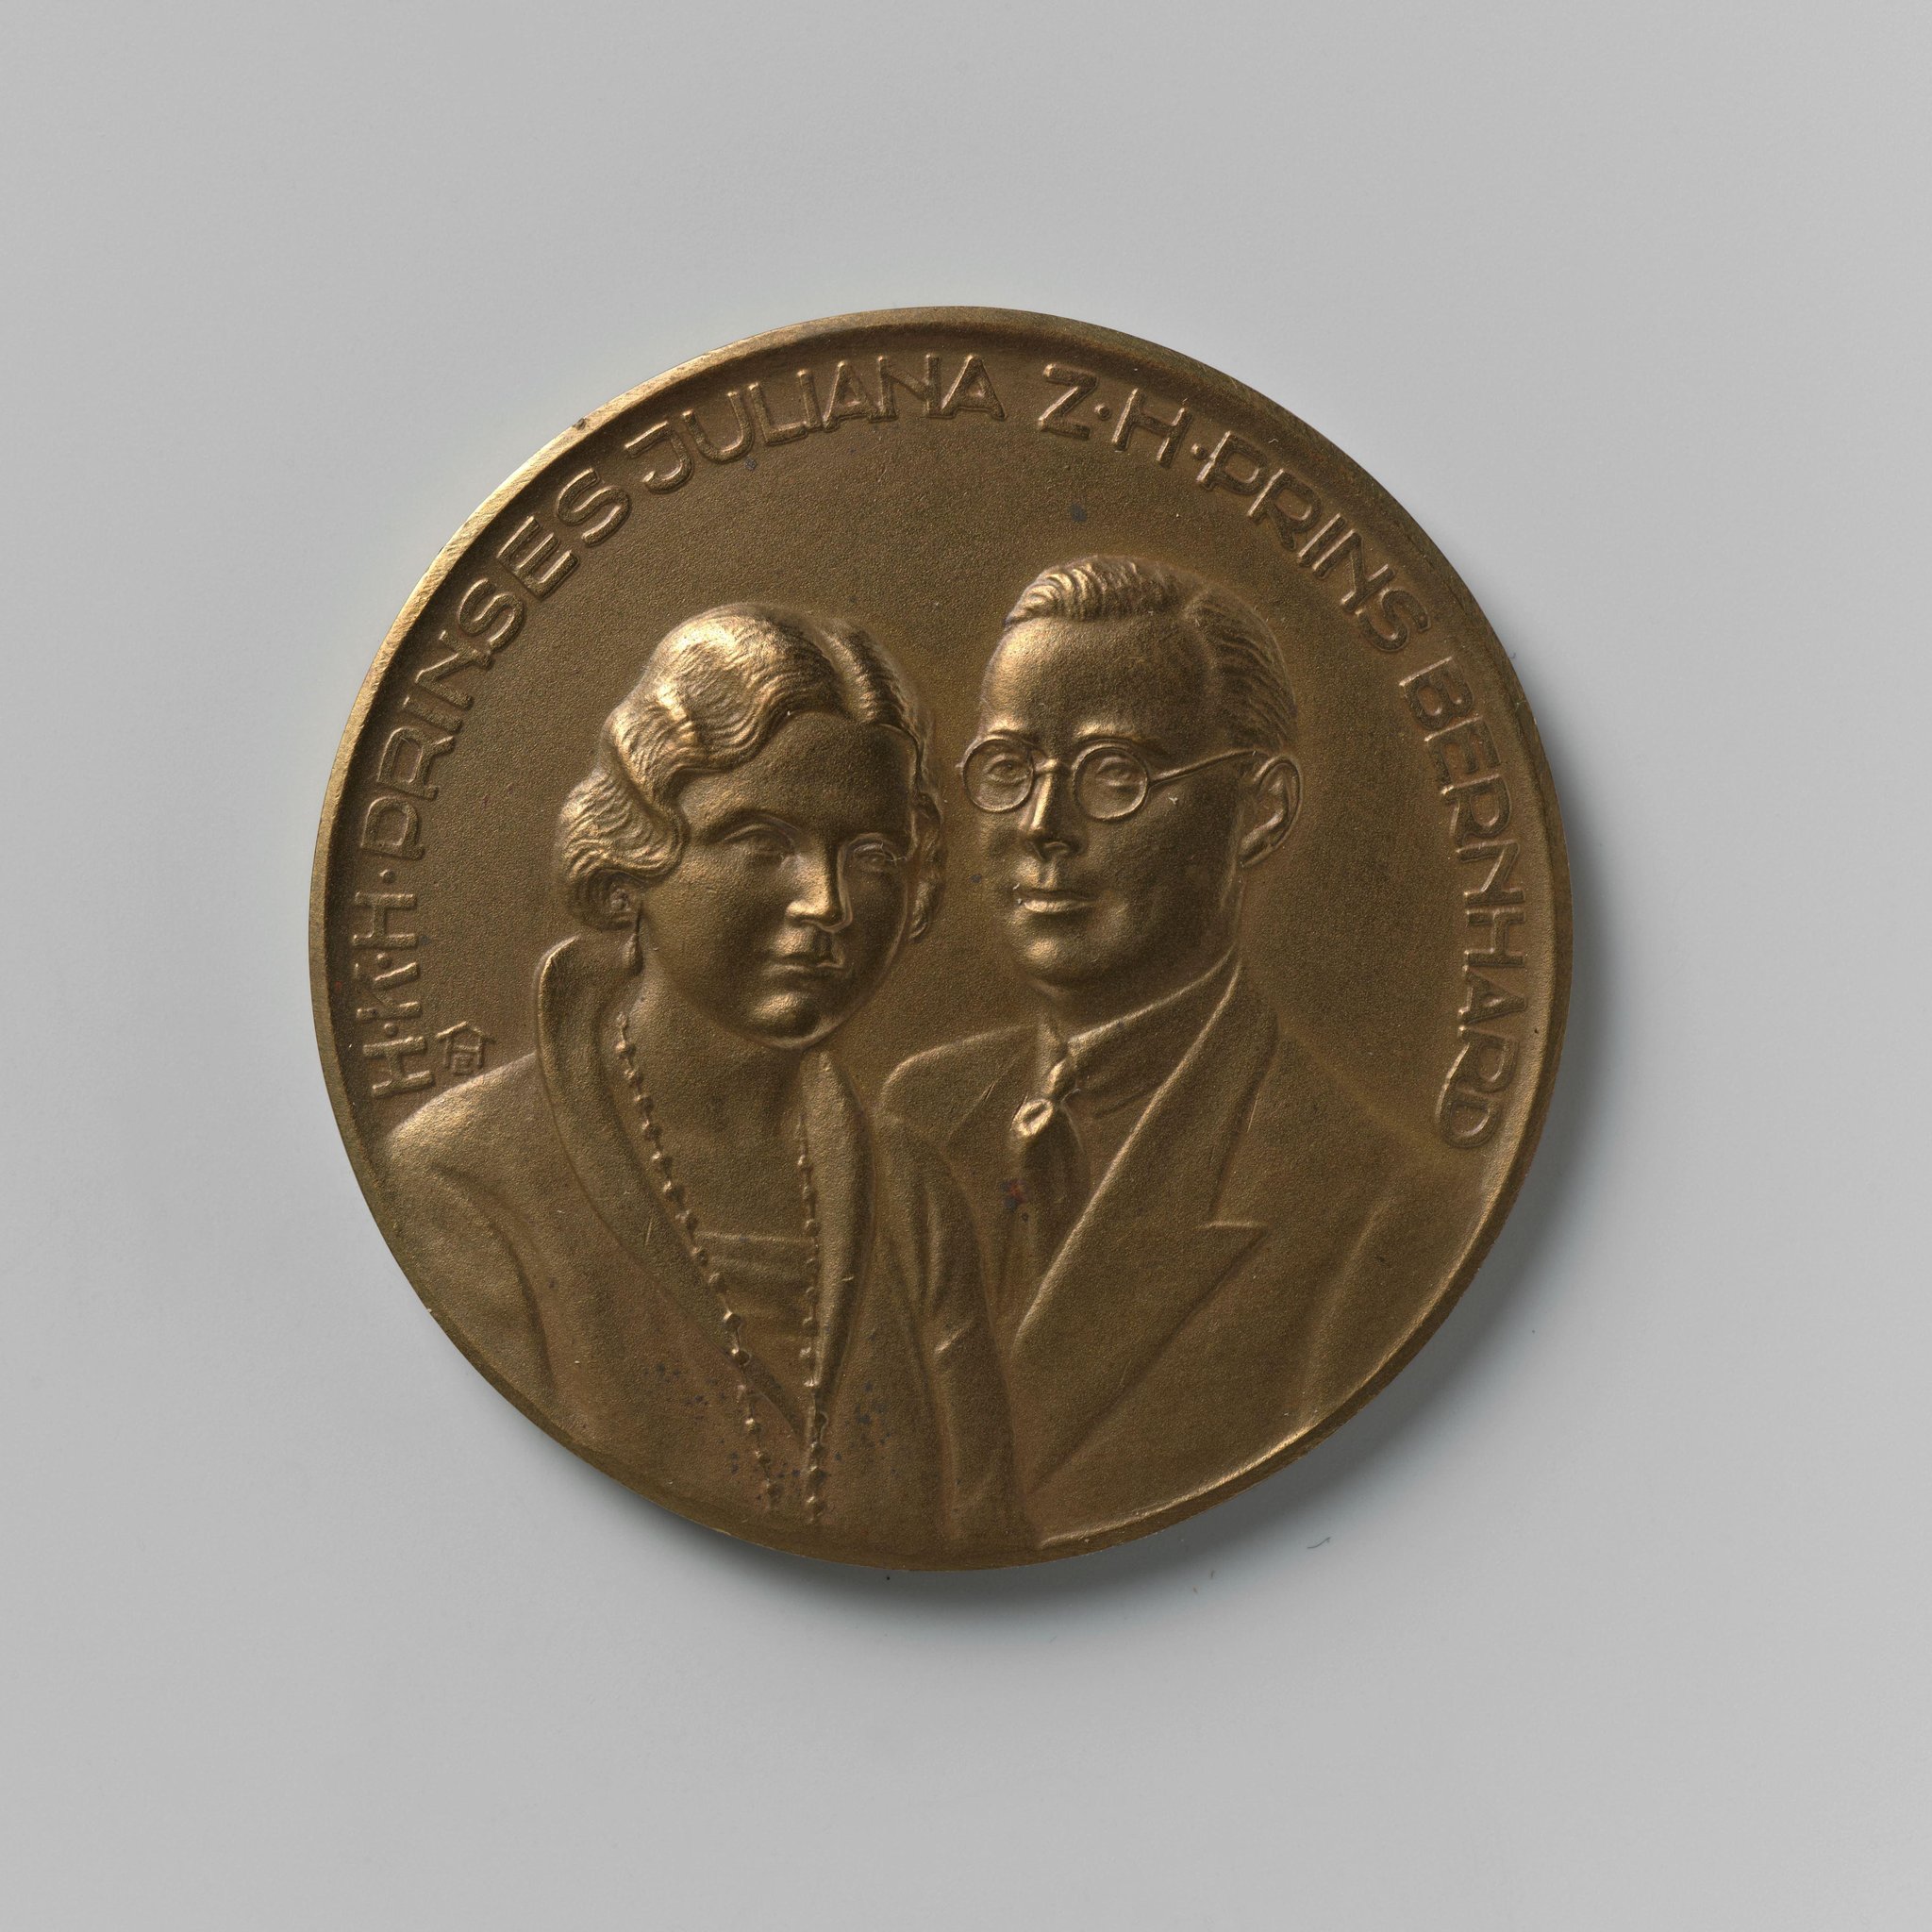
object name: history medal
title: Verloving van Prinses Juliana met Bernhard 1936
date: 1936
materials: bronze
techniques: striking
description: Bronzen penning, op de voorzijde de elkaar half toegewende borstbeelden van Juliana en Bernhard met bovenaan omschrift, op de keerzijde twee wapenschilden tegen een oranjeboom met één regel tekst.